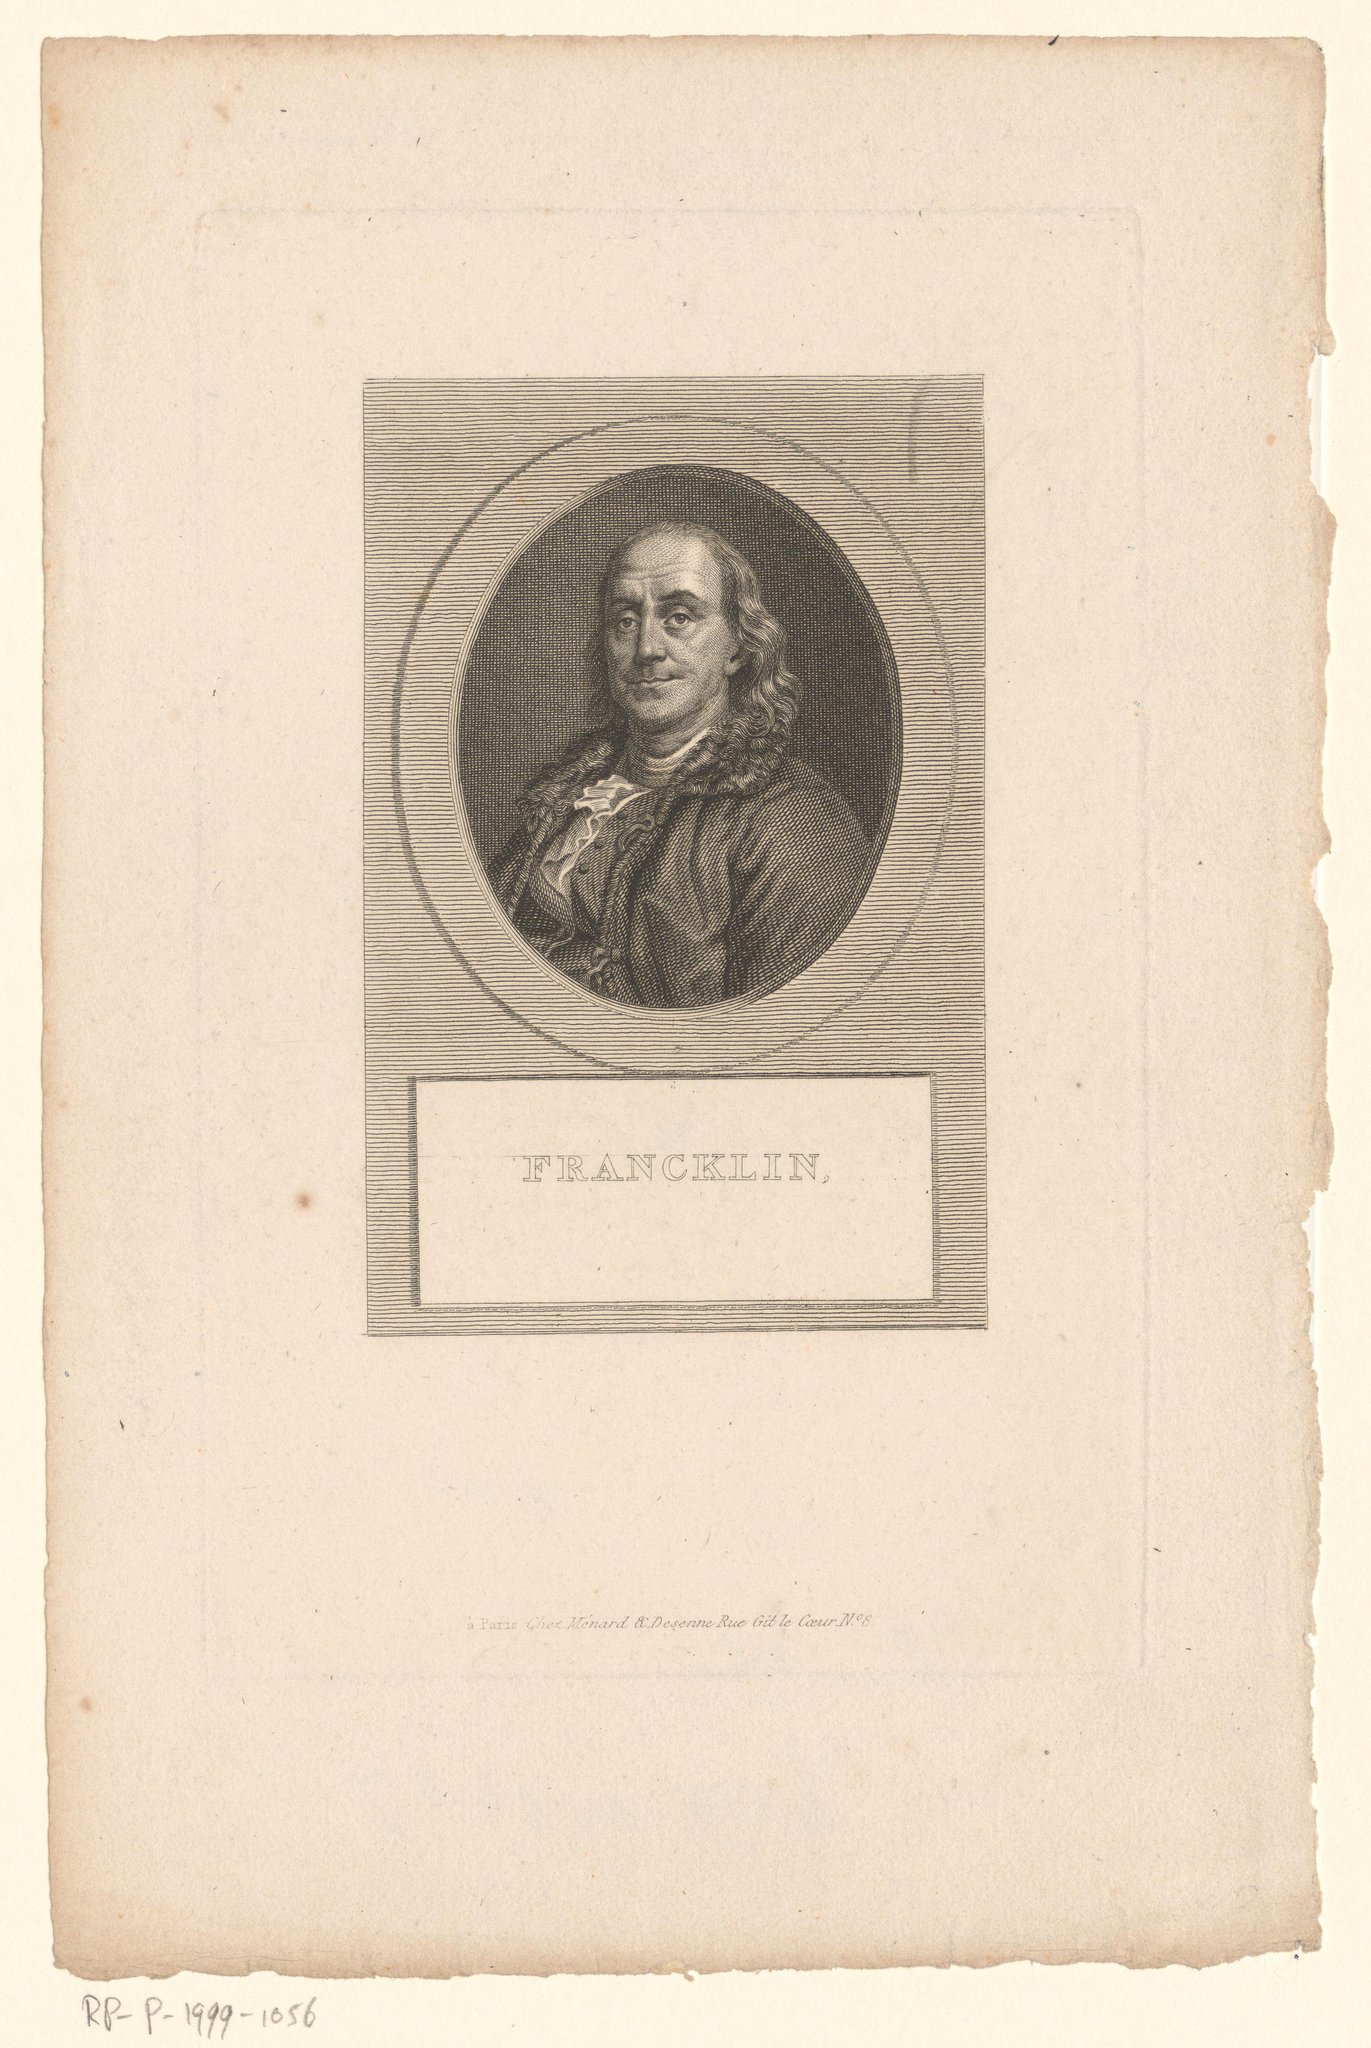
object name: print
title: Portret van Benjamin Franklin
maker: Anonymous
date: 1816-1831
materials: paper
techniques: etching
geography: paris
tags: physicist, historical persons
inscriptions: collector's mark: Lugt 2228, collector's mark: Lugt 2760